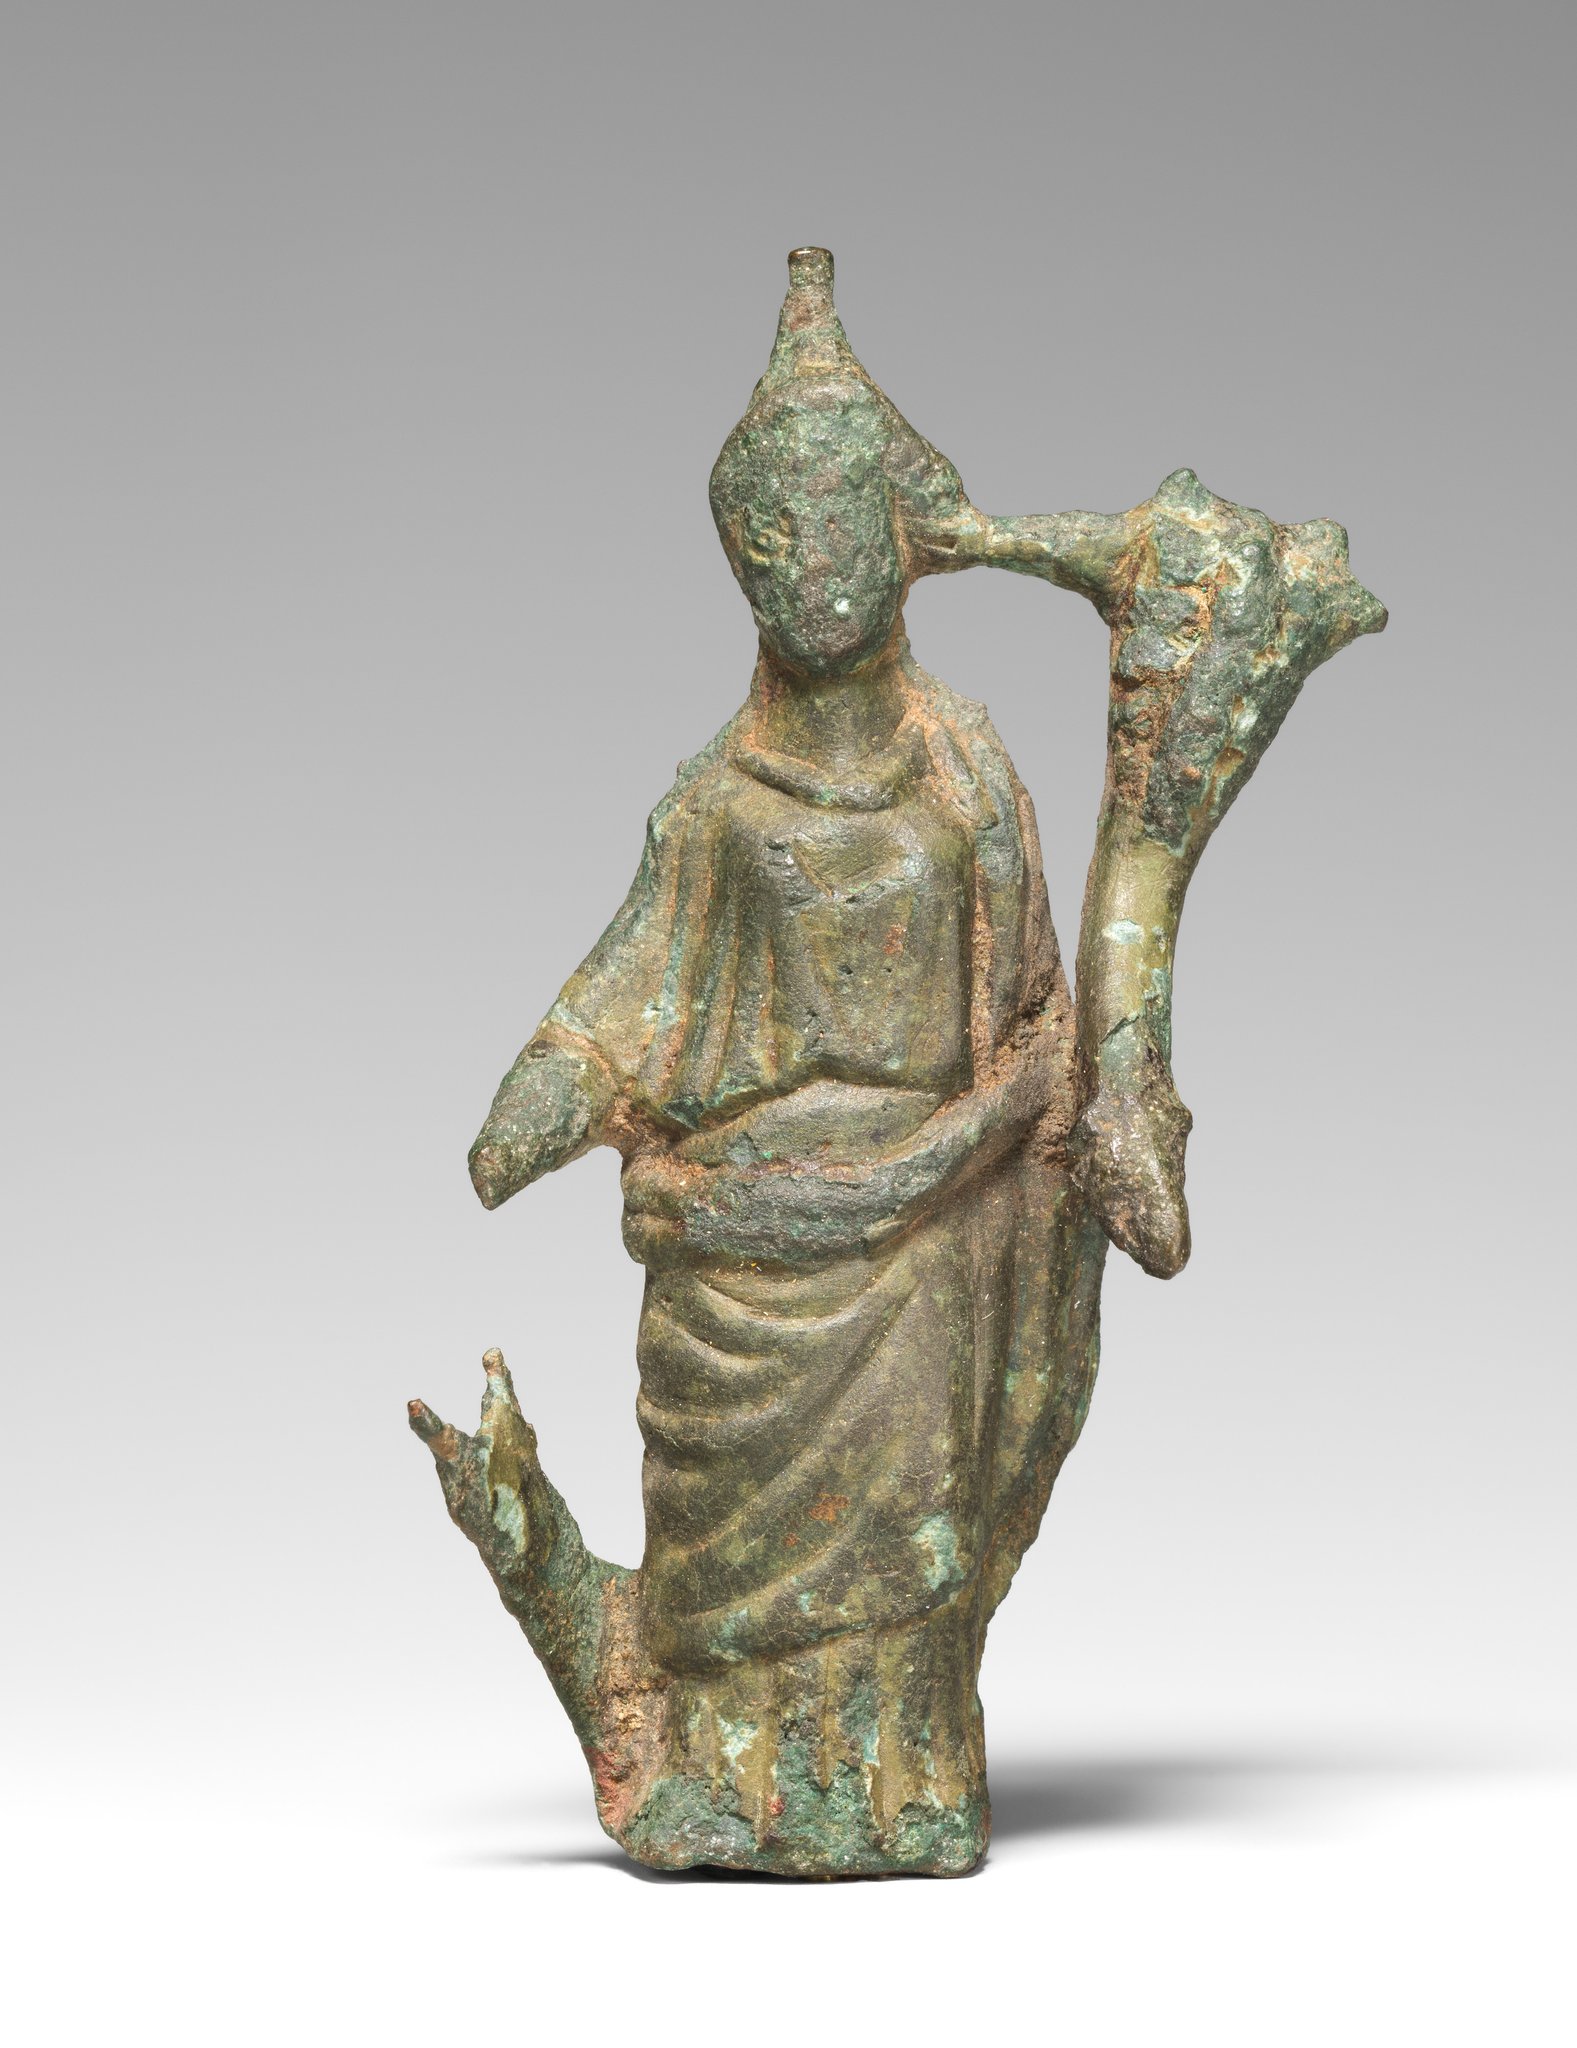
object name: statuette of fortuna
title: Bronze statuette of the goddess Fortuna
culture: roman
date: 101-200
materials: bronze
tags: diadems,cornucopia,goddess